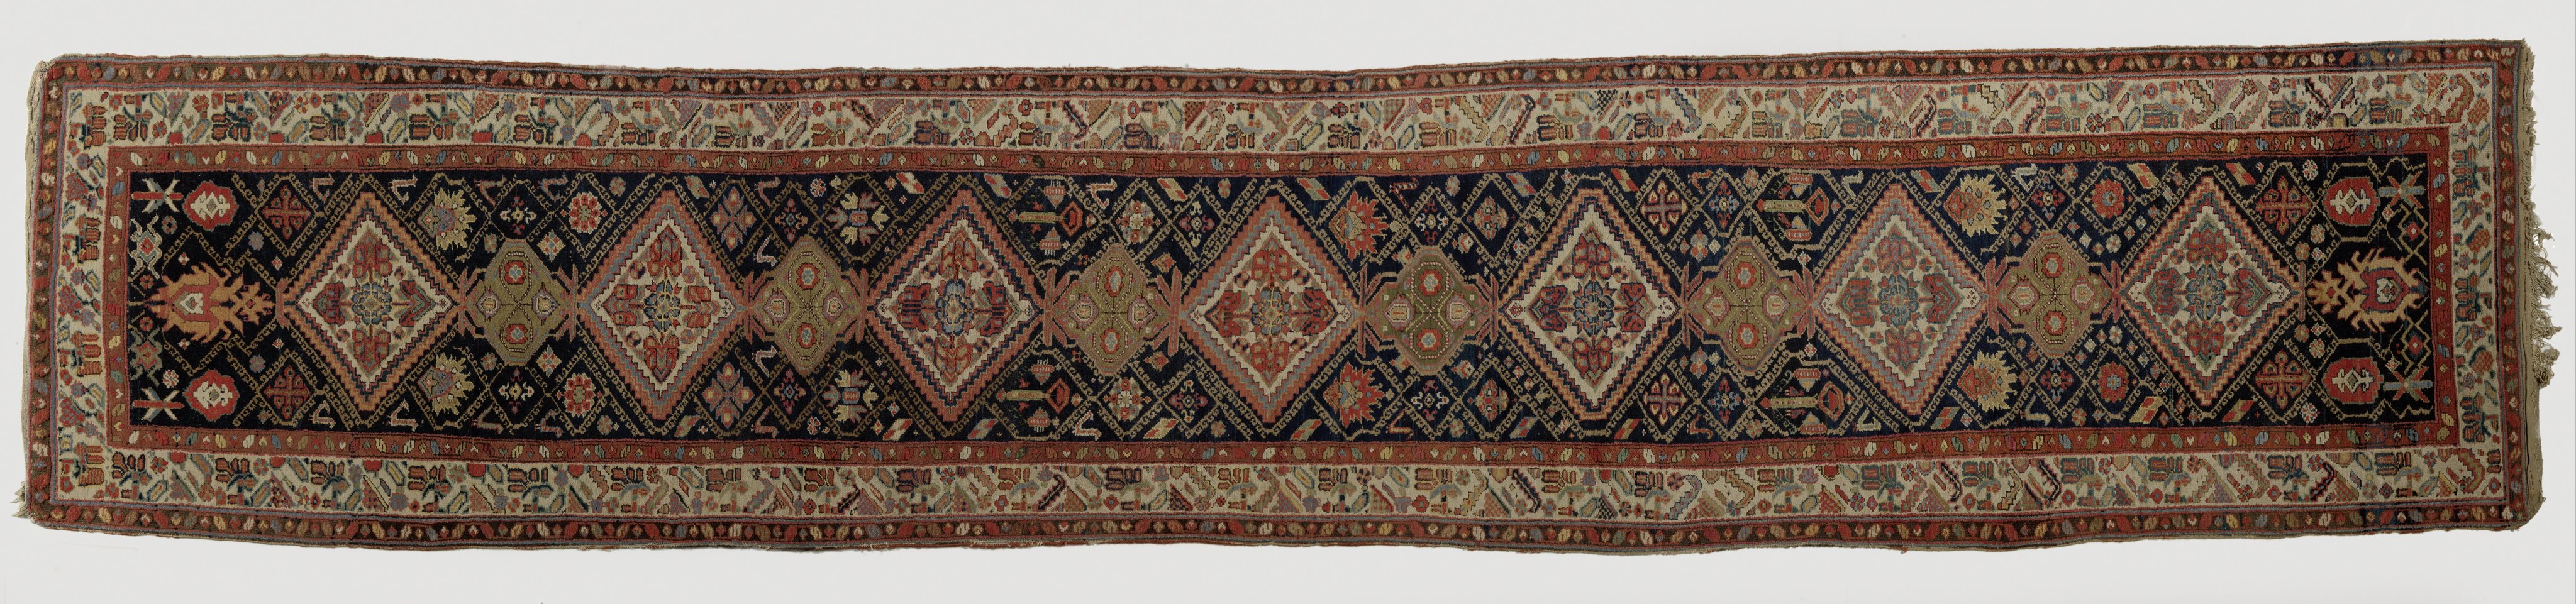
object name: oriental rug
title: Oosters tapijt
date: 1850-1900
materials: wool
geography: northwest persia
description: Oosters tapijt van geknoopte wol, medaillonkleed in loperformaat.